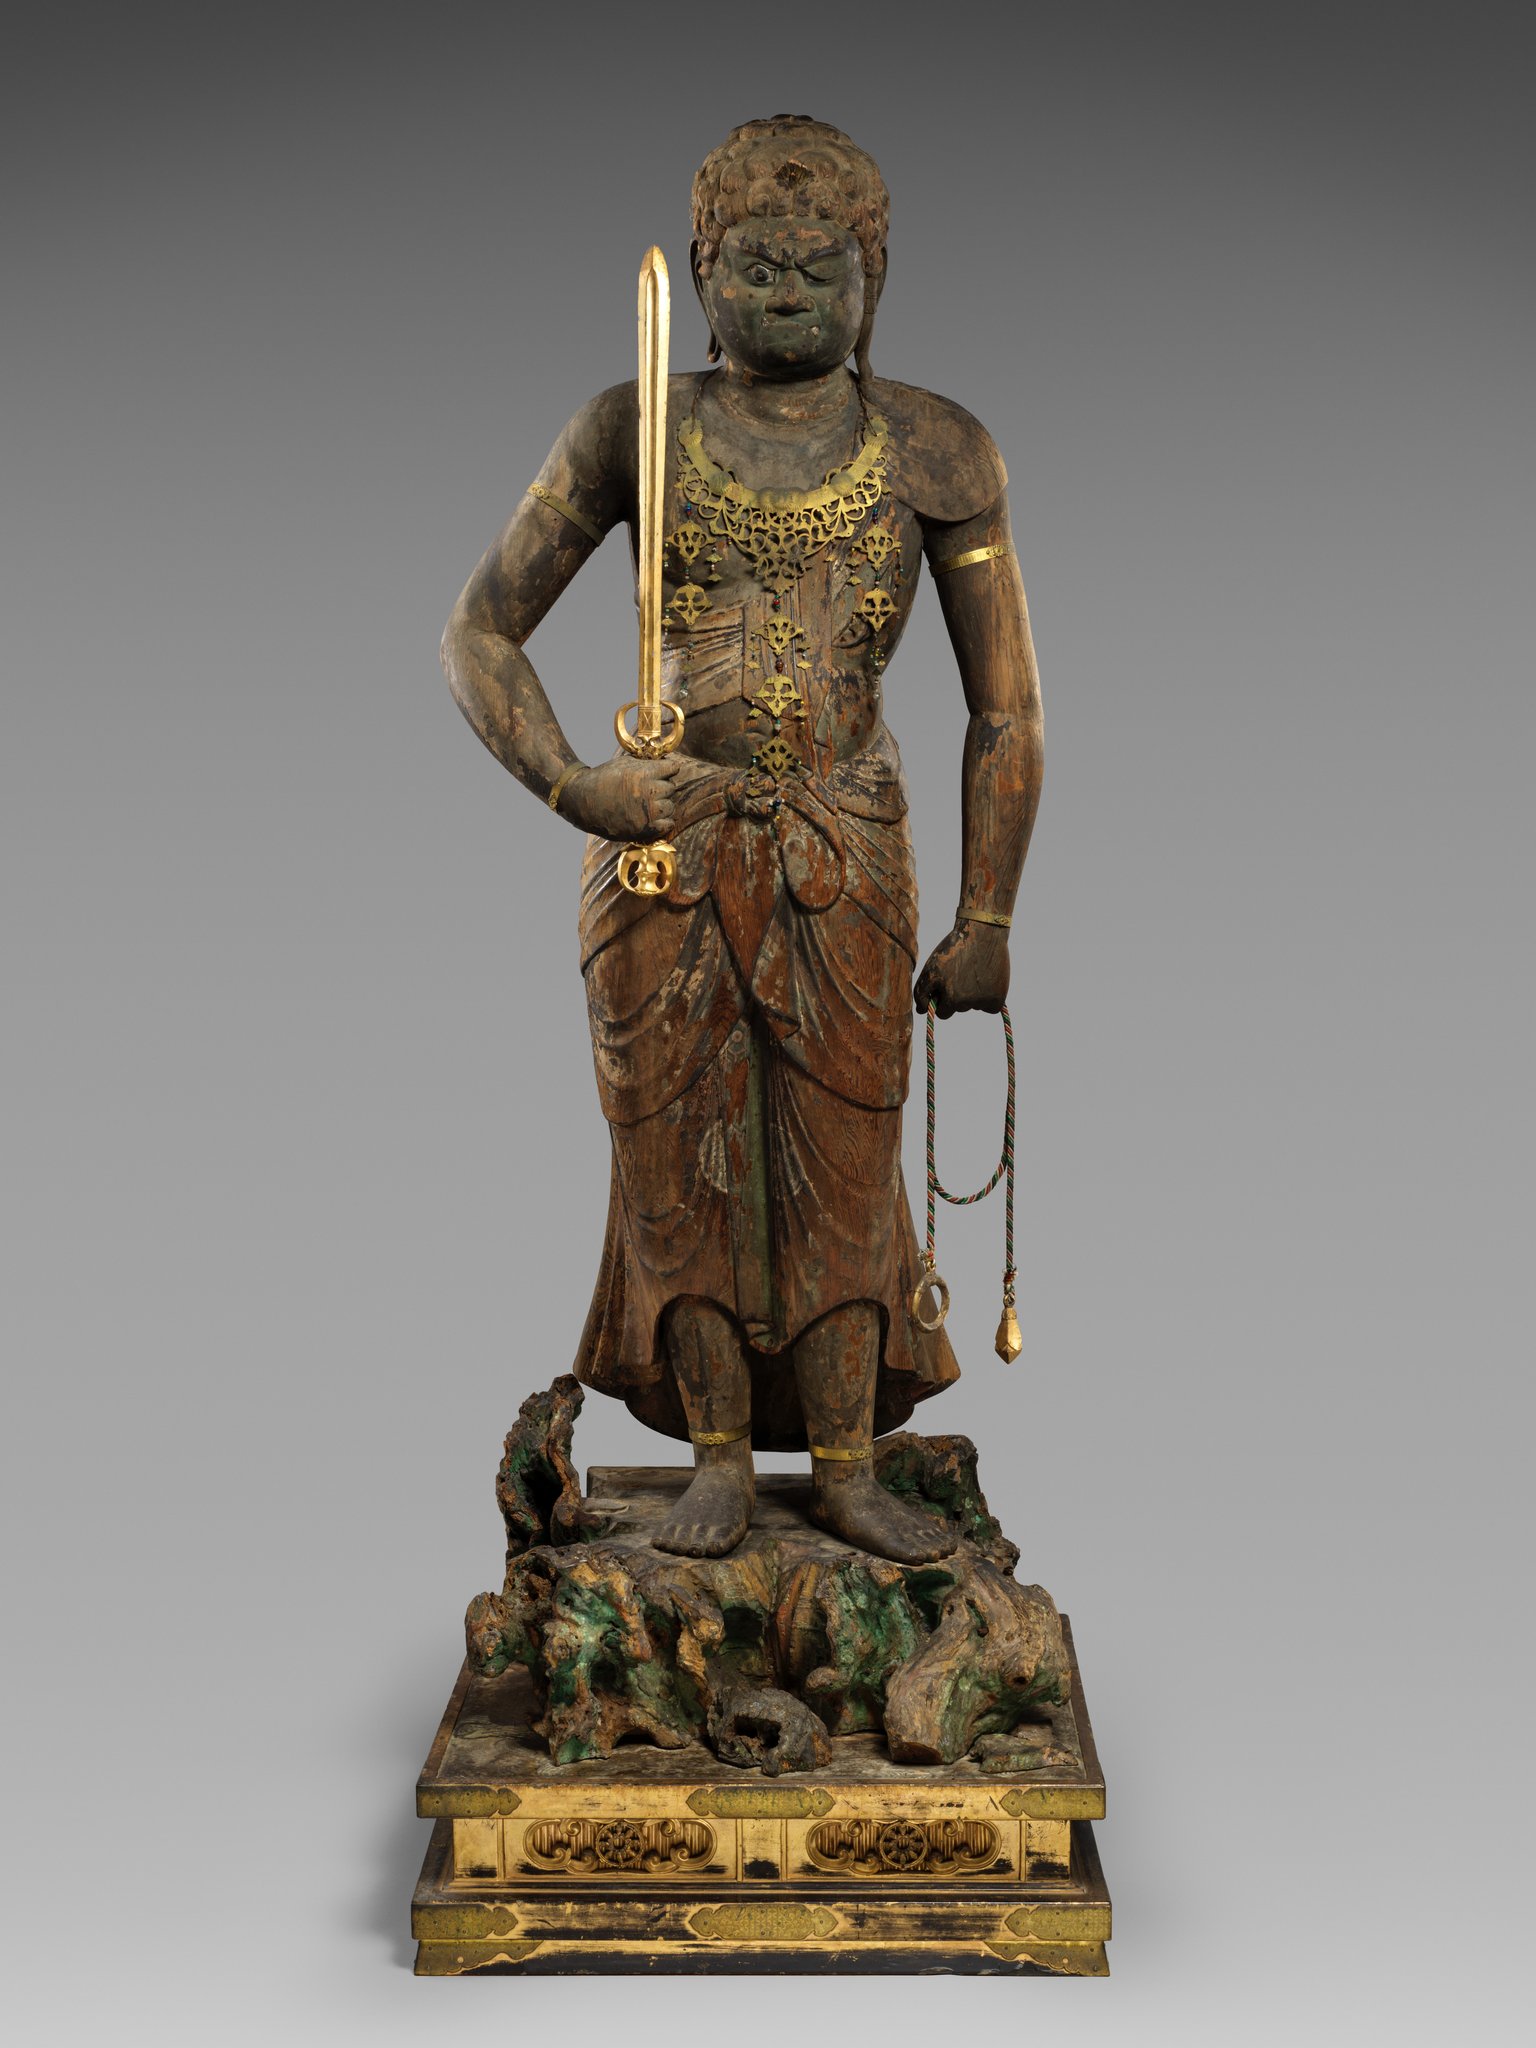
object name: figure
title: Fudō Myōō (Achala Vidyaraja)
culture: japanese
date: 1101-1200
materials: gold leaf, lacquer, wood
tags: swords,men,buddhism,deities